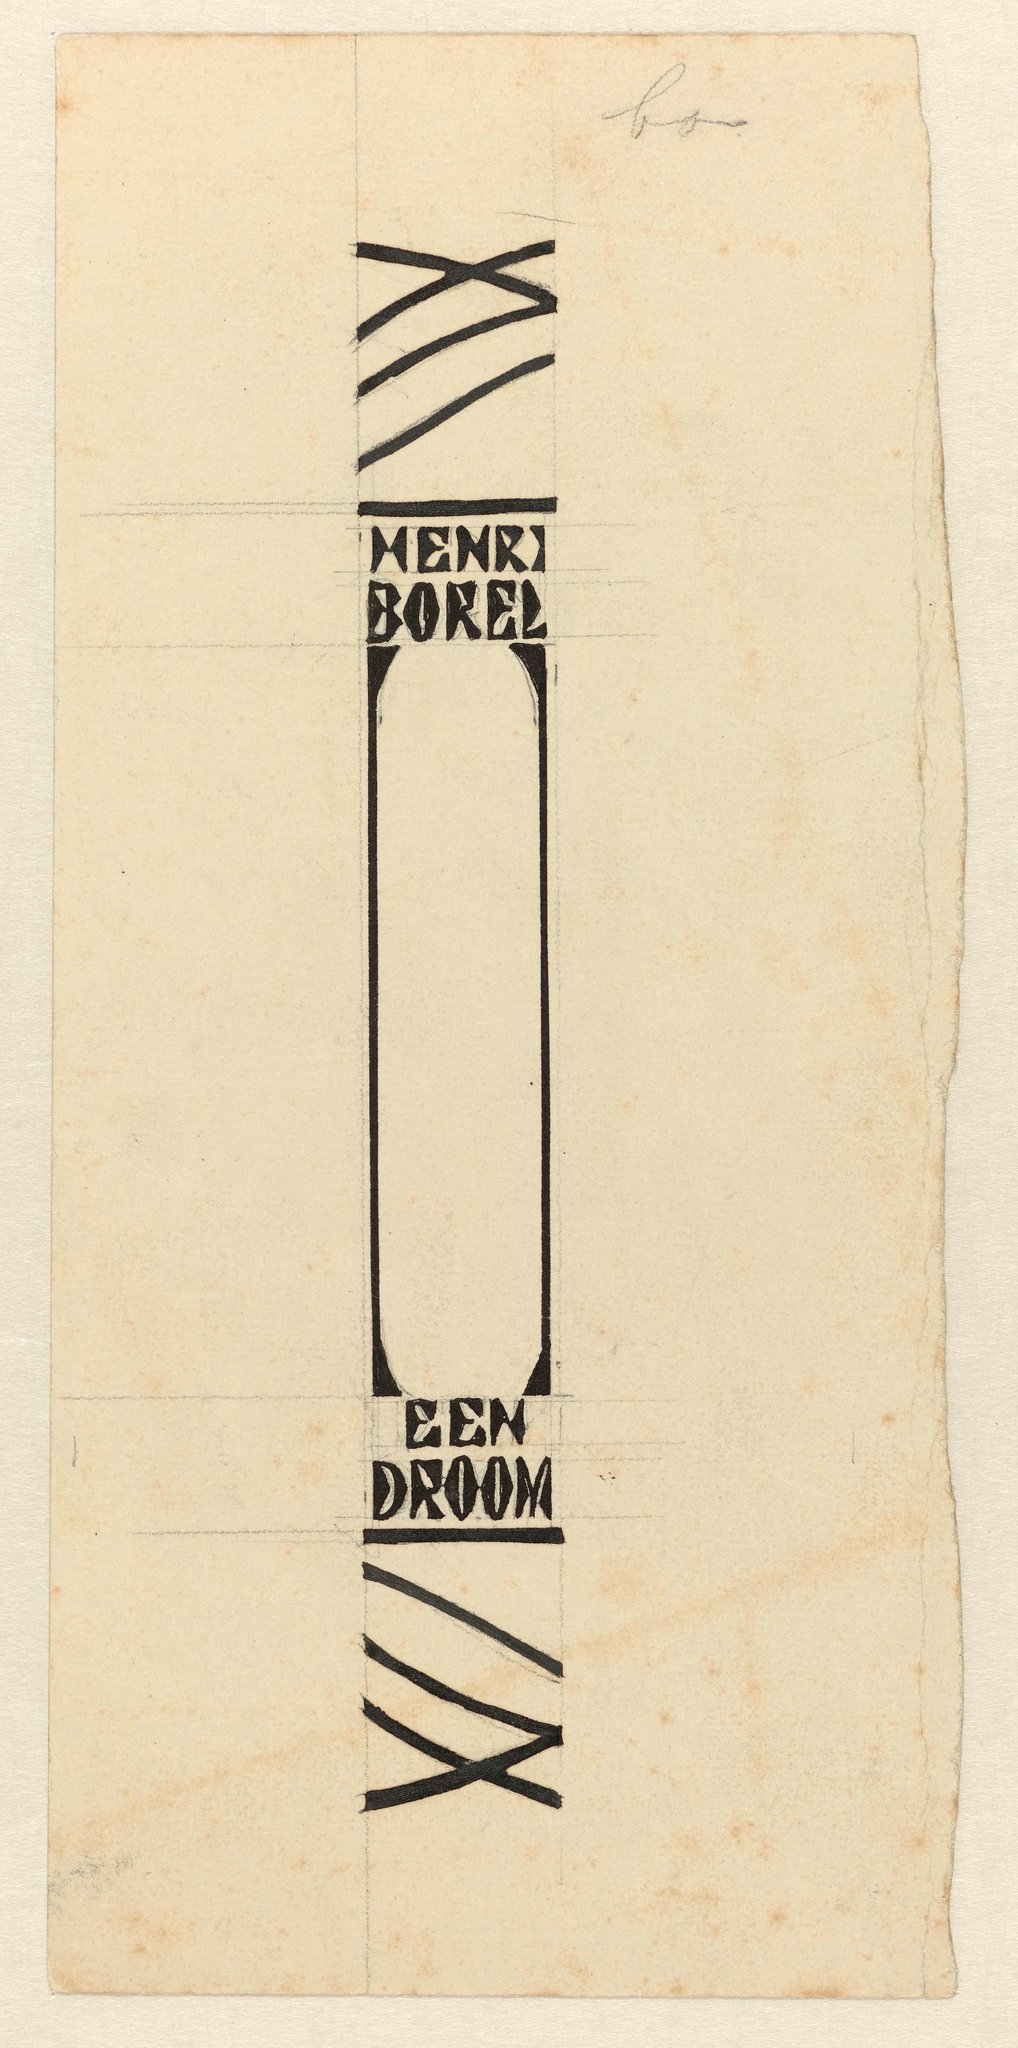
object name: drawing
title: Ontwerp voor een boekrug voor: Henri Borel, Een droom, 1899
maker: jan toorop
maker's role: draughtsman, painter, print maker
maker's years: 1858-1928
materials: ink, paper, pencil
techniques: pen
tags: intersecting lines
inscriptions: collector's mark: Lugt 2228a, annotation: ‘bo’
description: Het boek waarvoor het ontwerp werd gemaakt werd in 1899 uitgegeven bij uitgeverij P.N. Van Kampen te Amsterdam, niet bij Uitgeverij L.J. Veen.